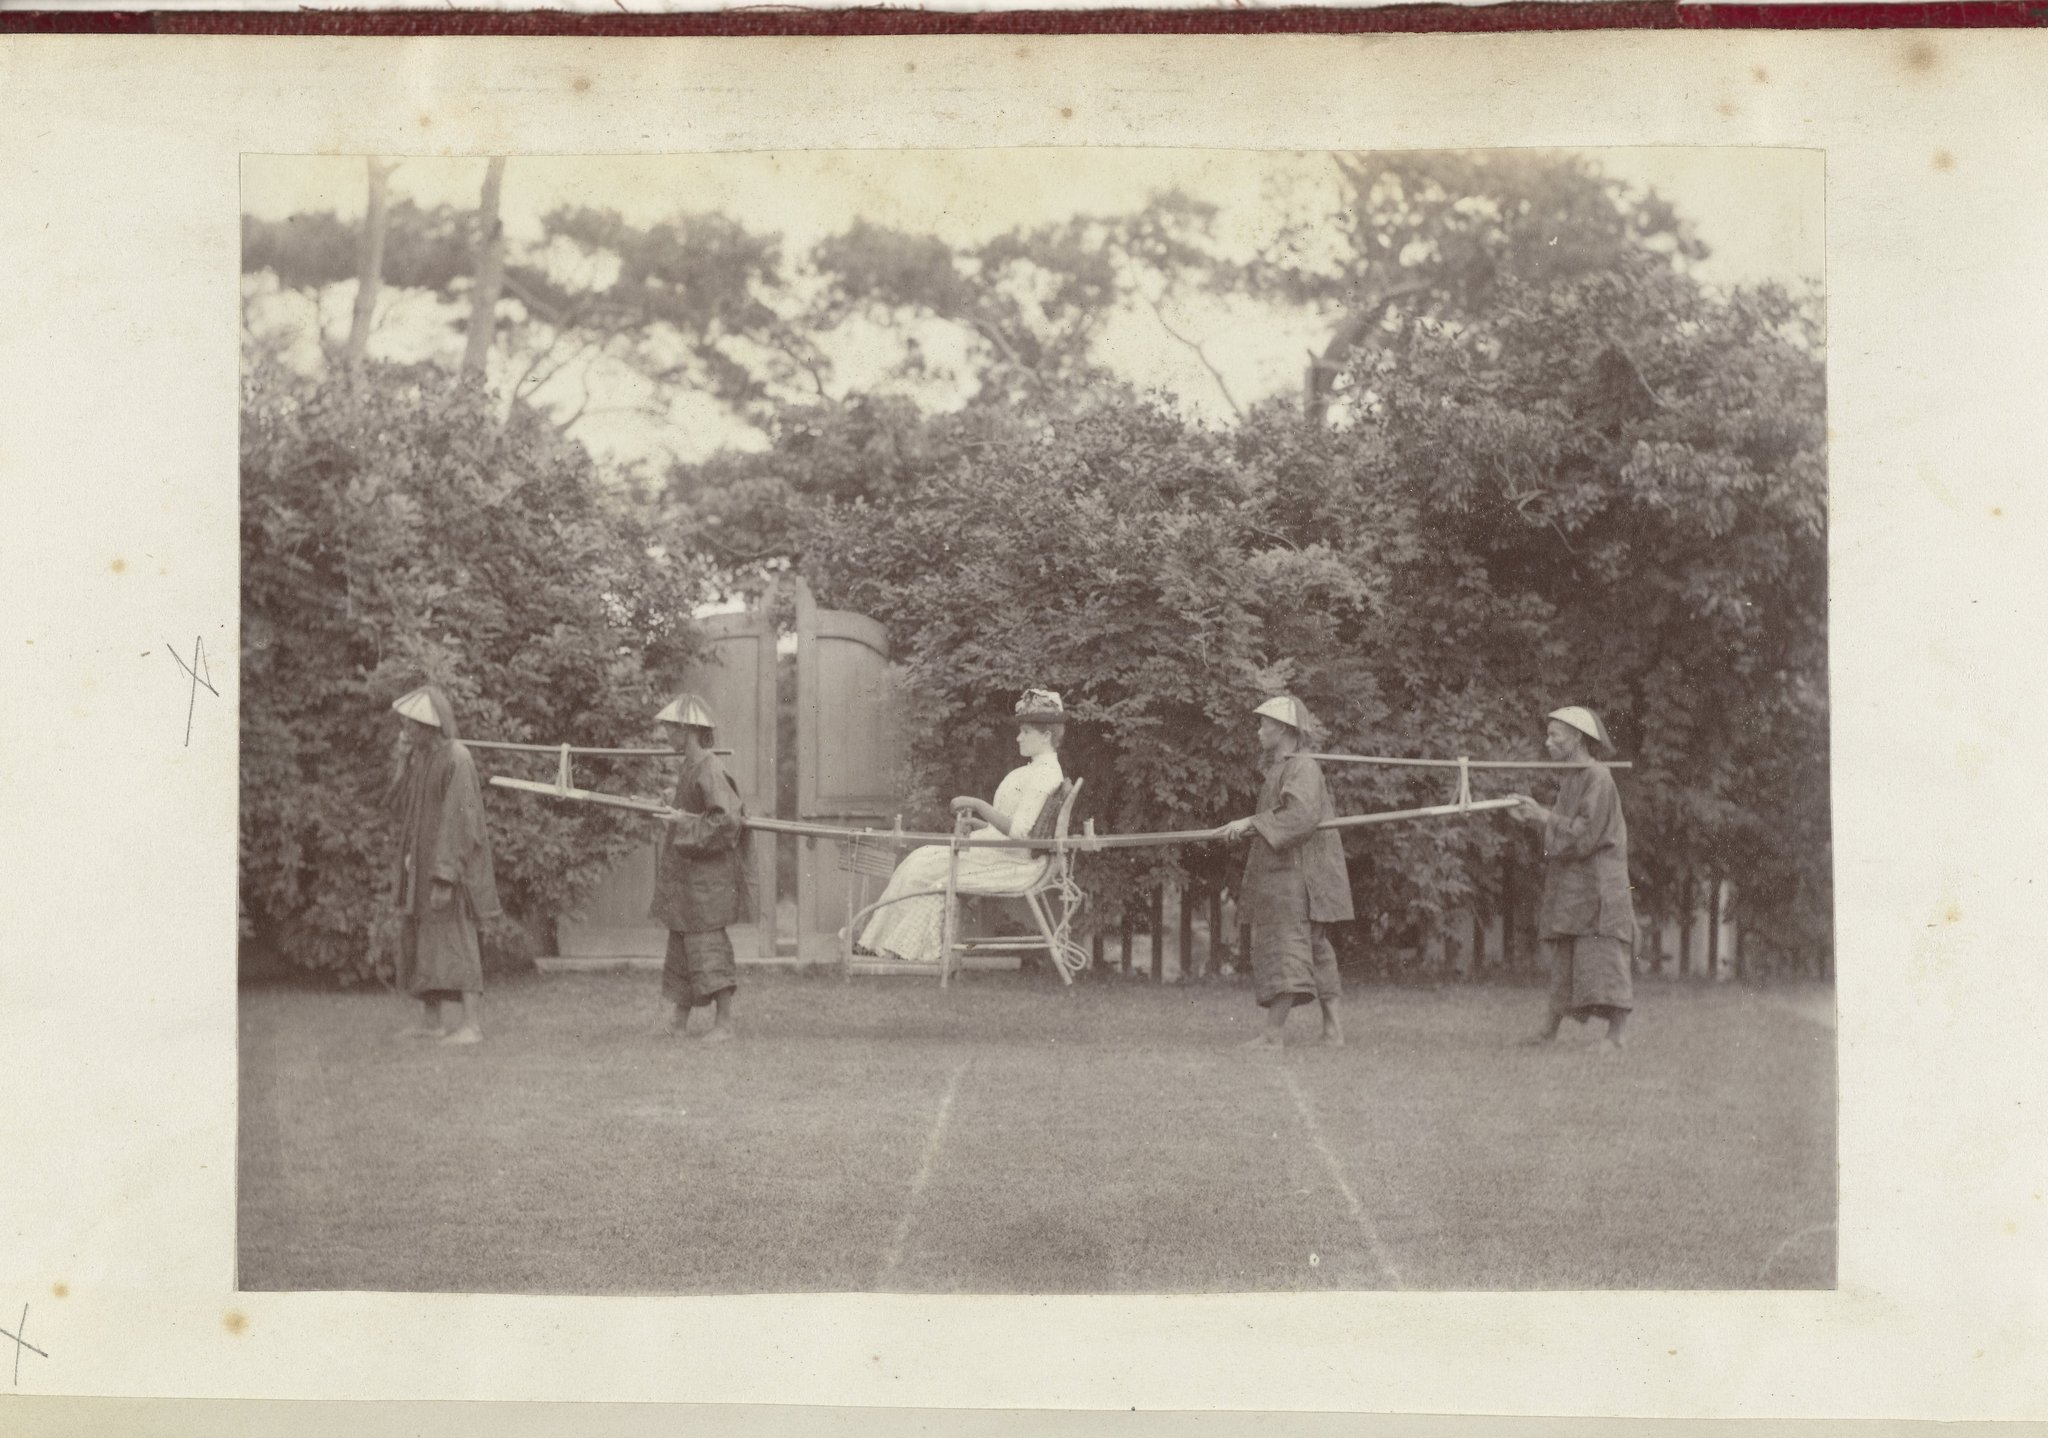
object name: album leaf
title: Vier Chinese mannen dragen een Europese vrouw in een draagstoel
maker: Anonymous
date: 1879-1890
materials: paper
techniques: albumen print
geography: china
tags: colonial system, (carrying a person in a) sedan-chair, china